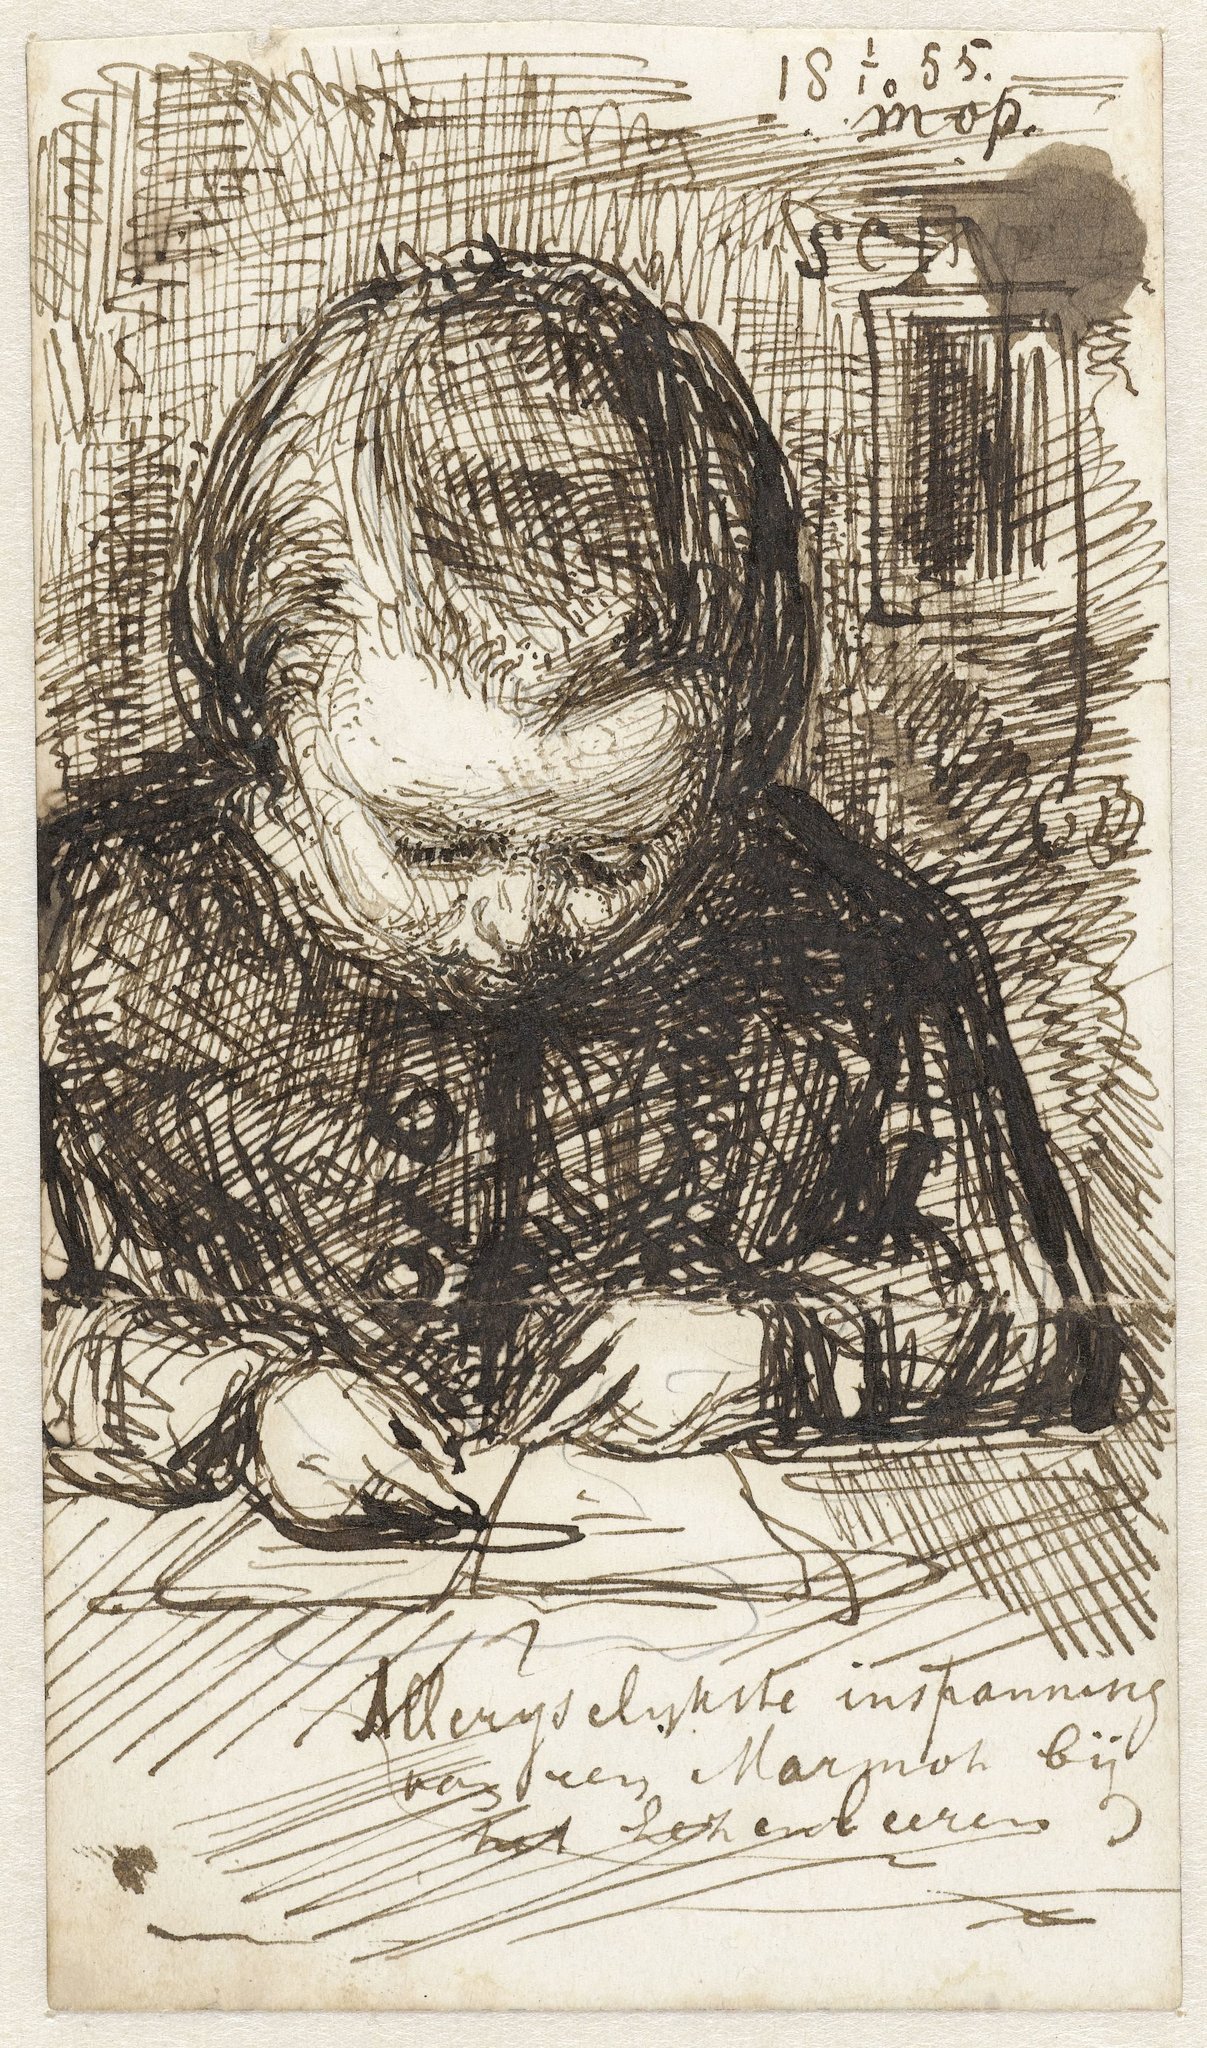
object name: drawing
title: Allerafgrijselijkste inspanning van een marmot bij het leren lezen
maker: august allebé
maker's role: draughtsman, print maker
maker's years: 1838-1927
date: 1855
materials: ink, paper, pencil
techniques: pen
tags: reading, elementary school; class, form